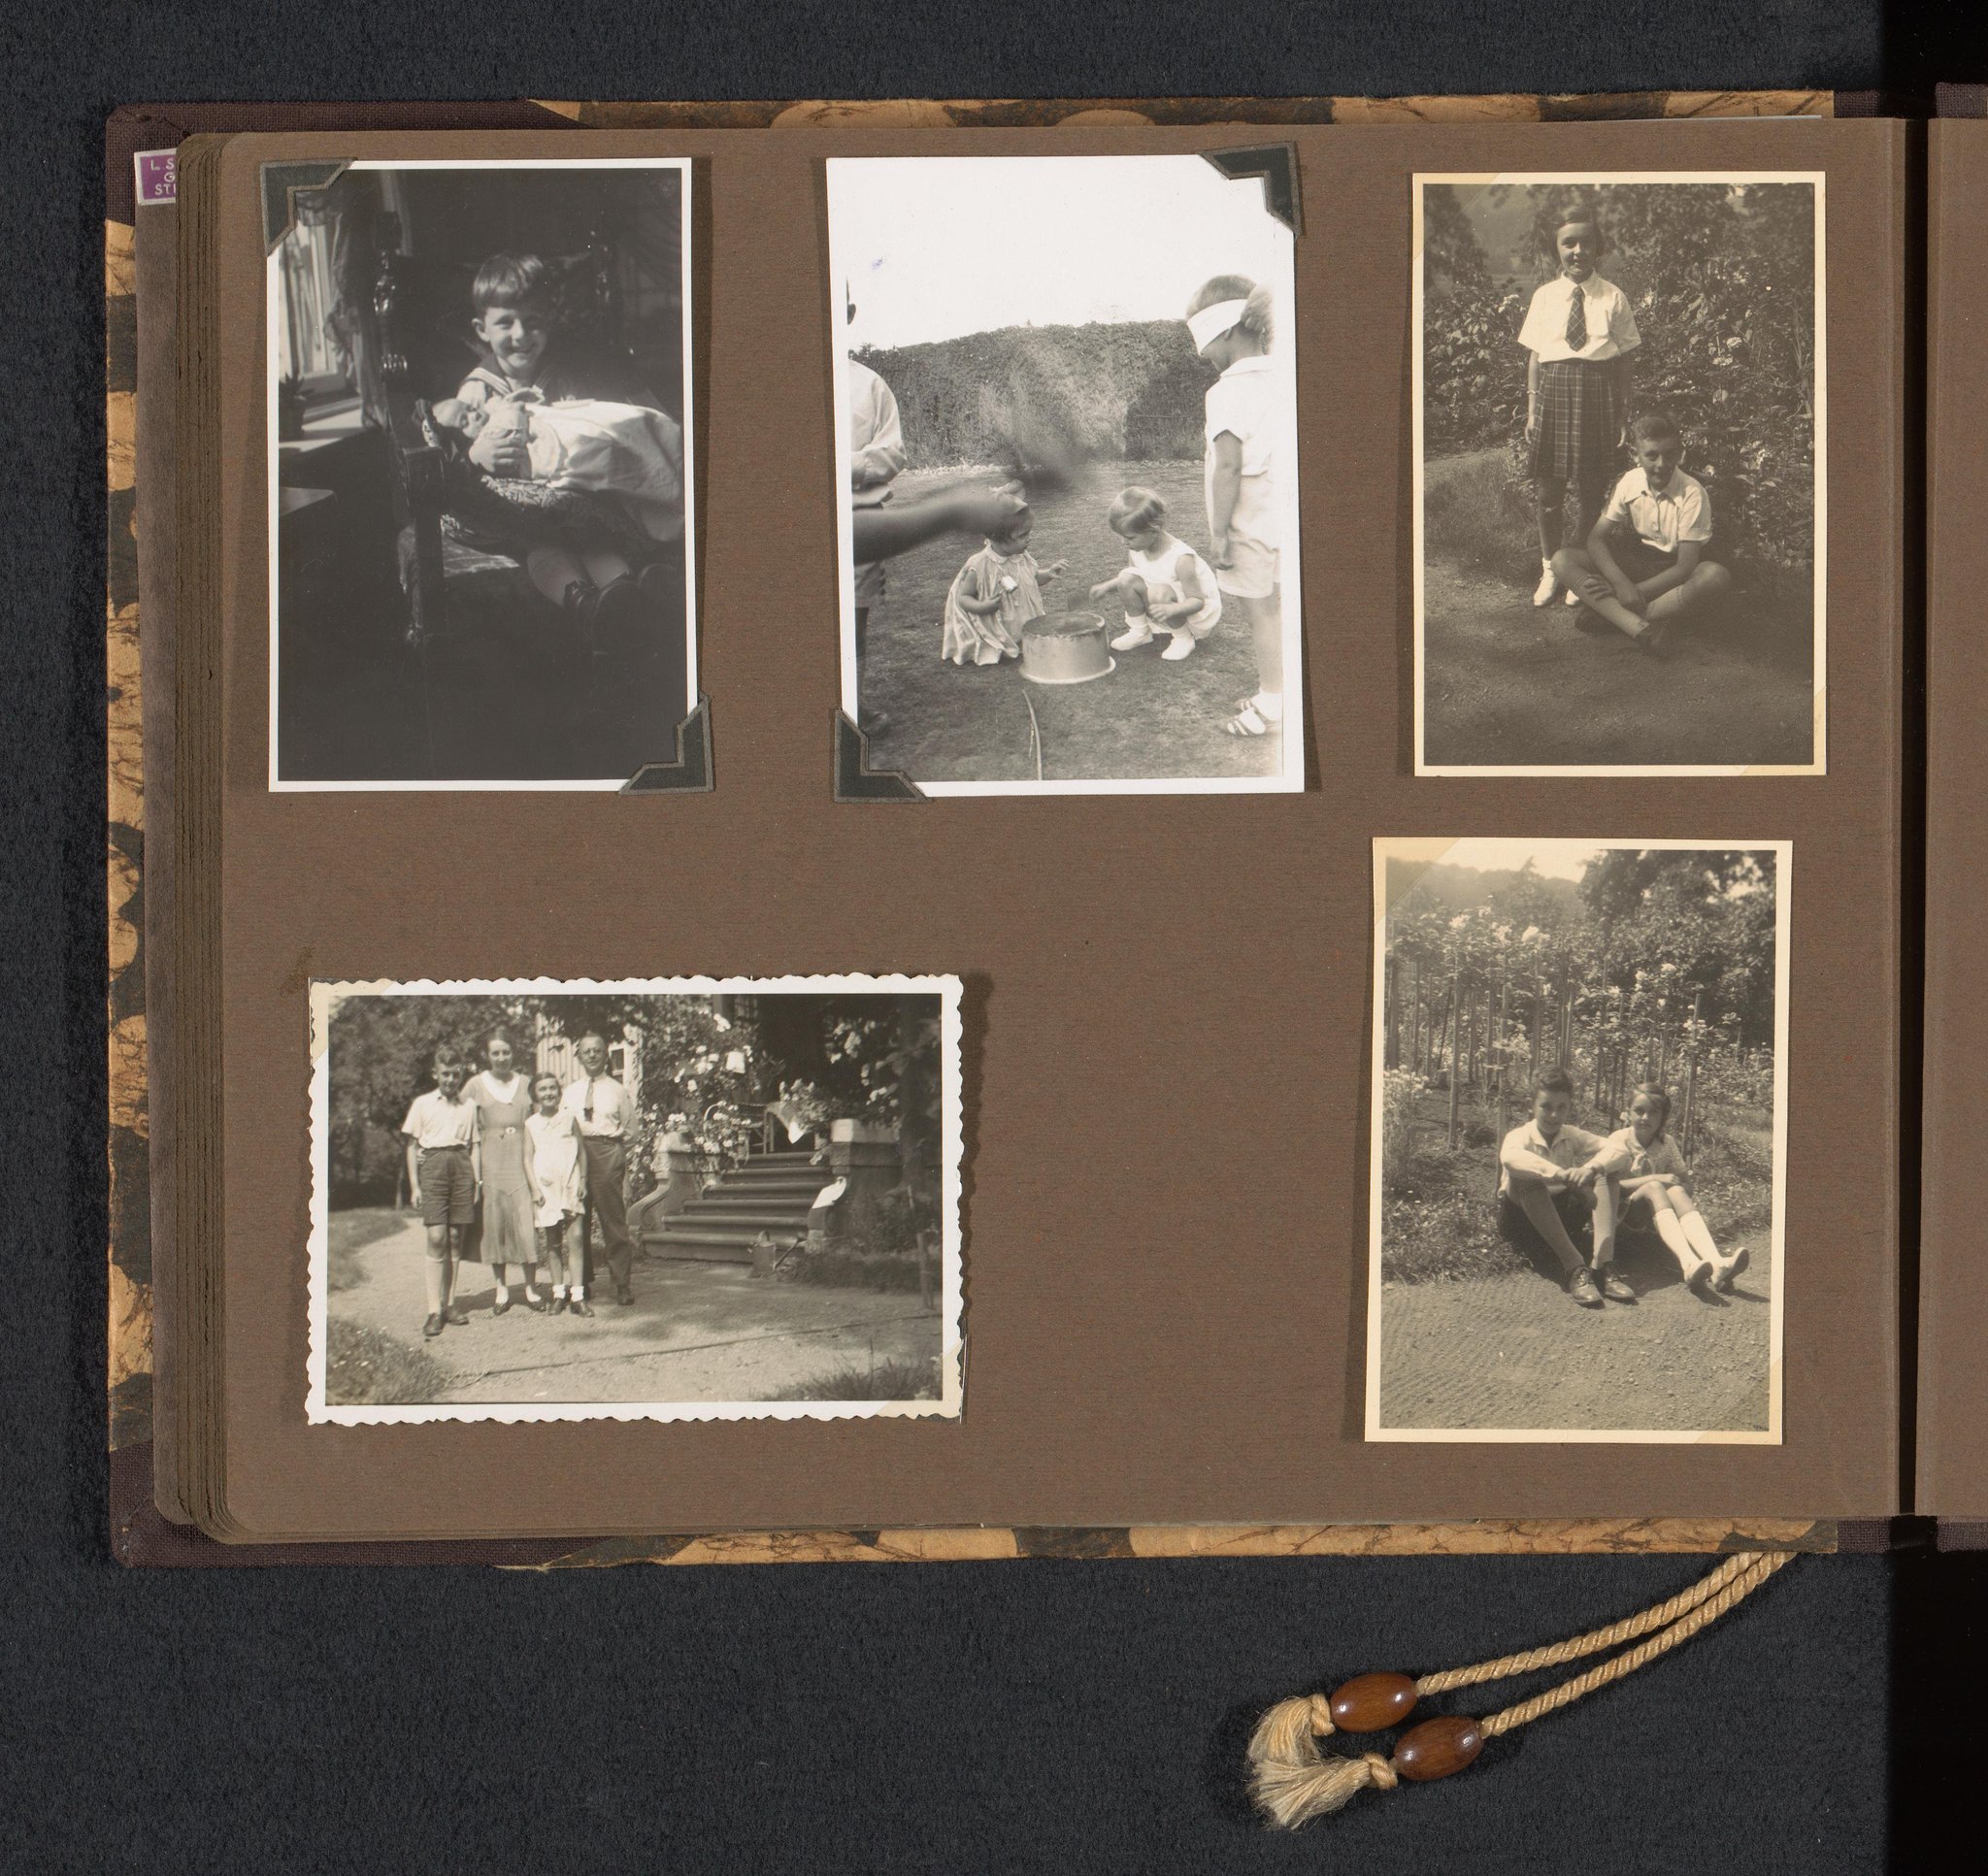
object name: photograph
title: Onbekende personen, mogelijk tijdens rondreis van Eugen Wachenheimer en Else Wachenheimer-Moos door Bulgarije, 1926-1927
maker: else wachenheimer-moos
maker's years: 1895-1944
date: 1926-1927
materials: paper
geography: bulgaria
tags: bulgarije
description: Albumblad bevat vijf foto's van onbekende personen. Afkomstig uit album half formaat, kartonomslag met koordbinding en lichte veelvormige vormen op voorzijde.